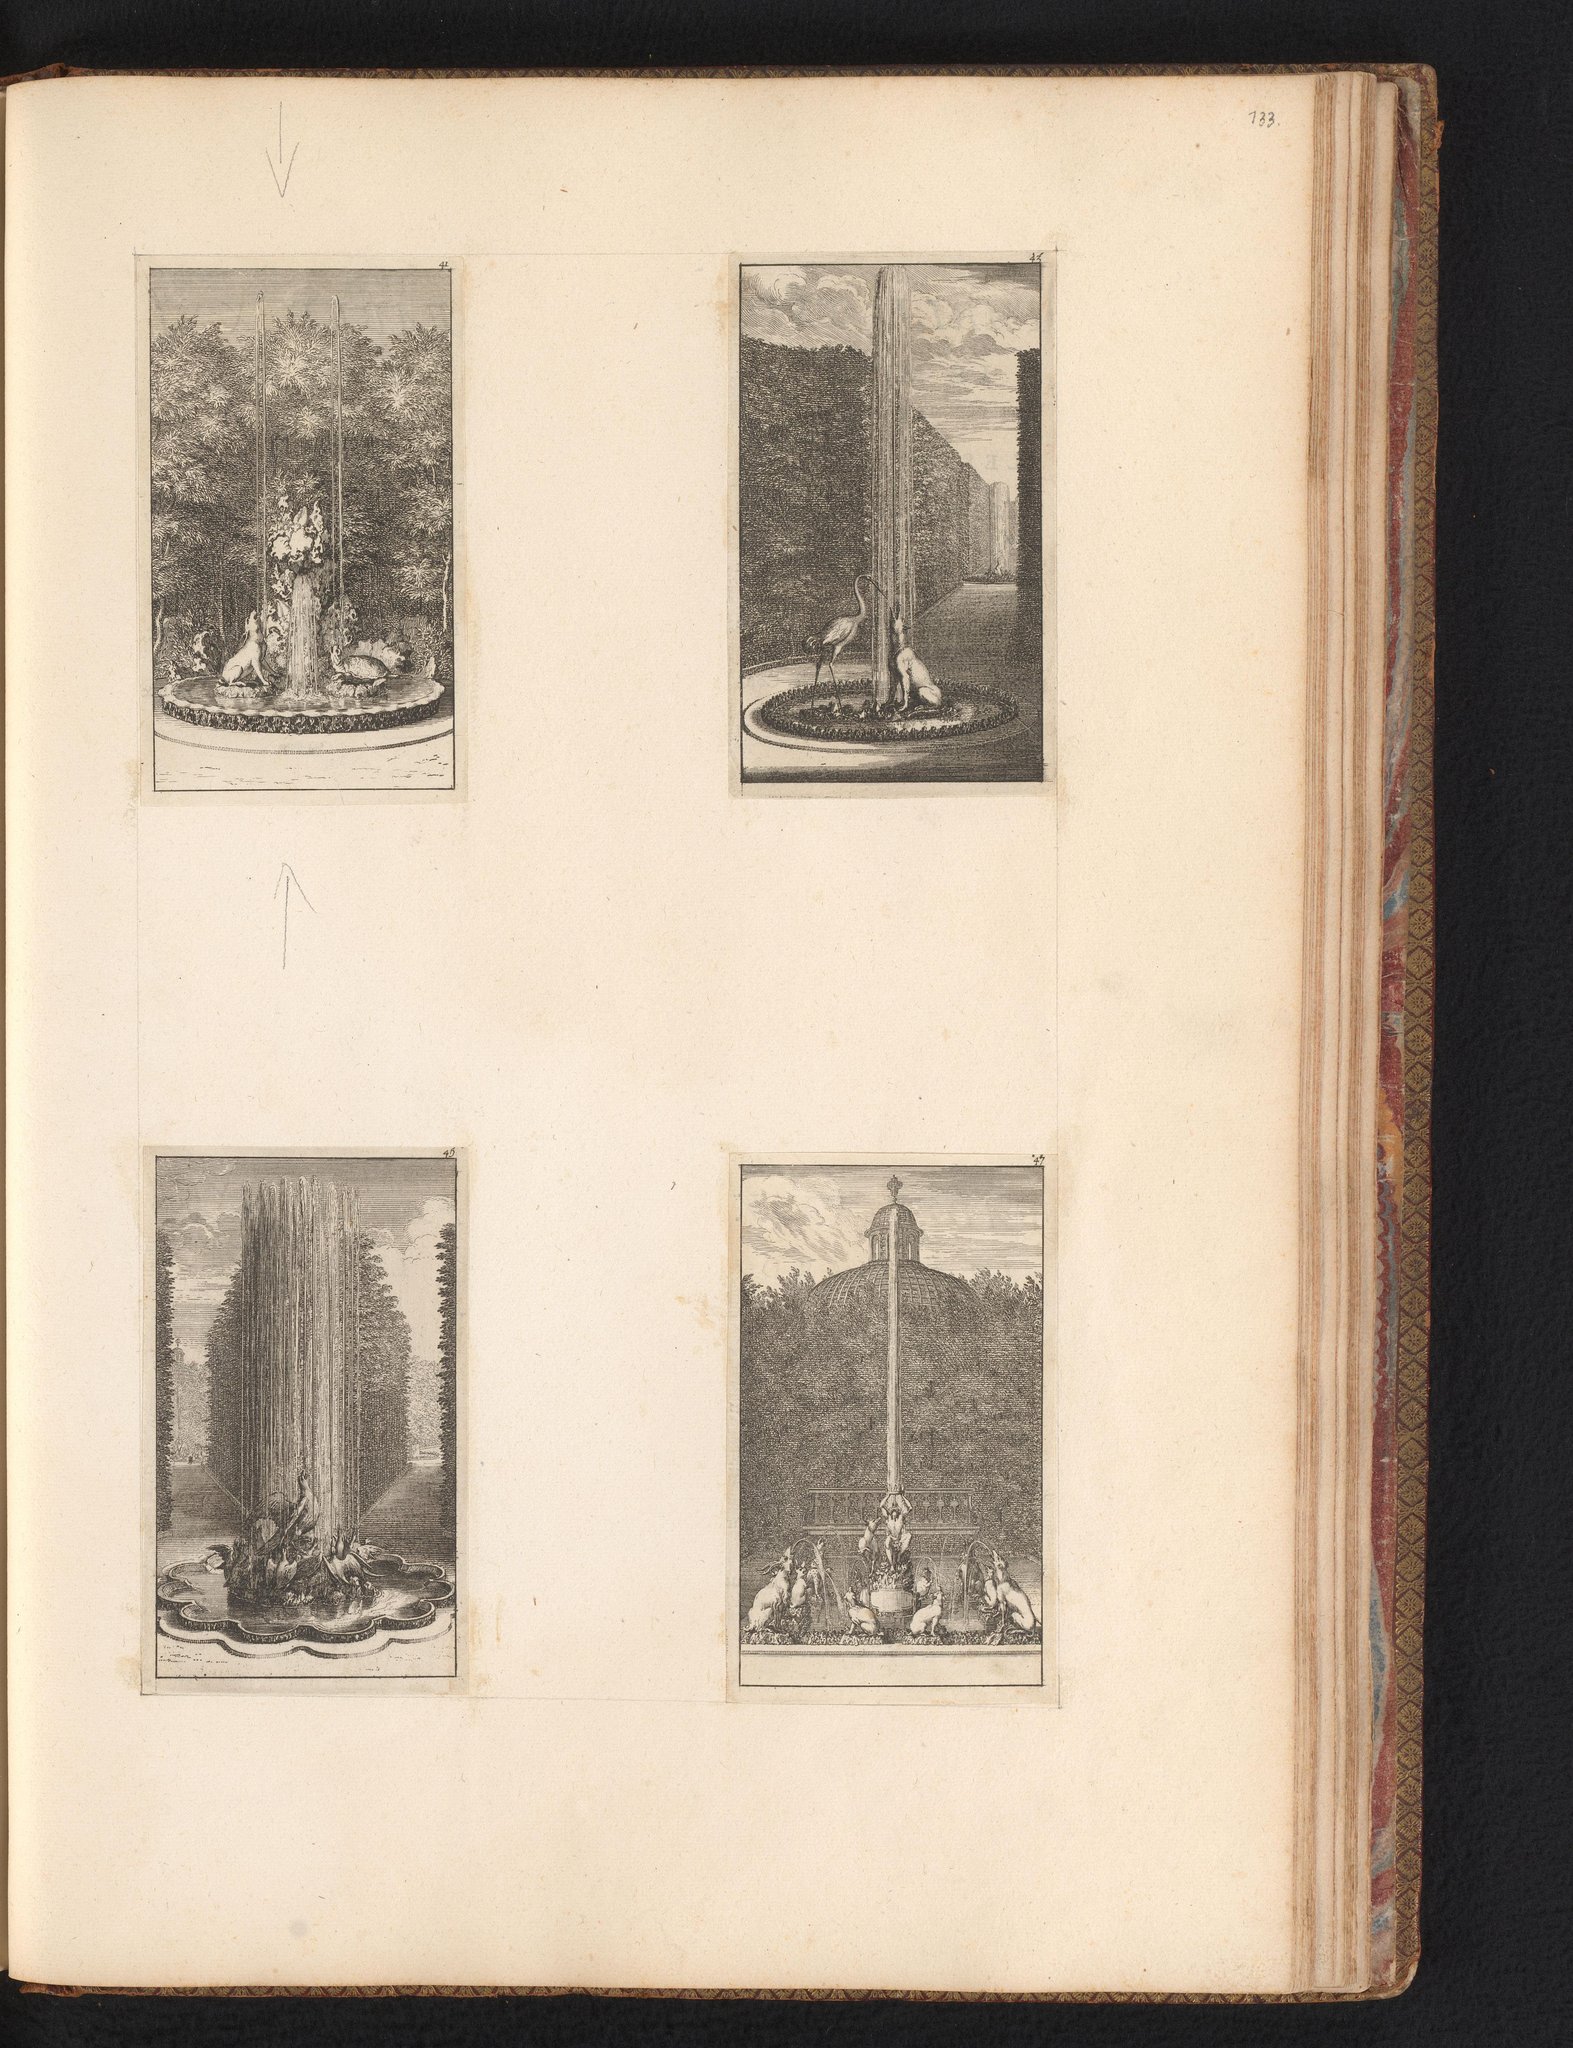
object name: album leaf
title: Vier gezichten op het labyrint van het Paleis van Versailles met fonteinen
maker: sébastien leclerc (i)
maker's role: print maker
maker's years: 1637-1714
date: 1677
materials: paper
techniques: etching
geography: paris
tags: garden fountain, fables of aesop : use 85(...), labyrinth, maze ~ garden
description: Prenten uit: Perrault, Charles. Labyrinthe de Versailles. Parijs: Imprimerie Royale, 1677. Hierin staan veertig prenten van het labyrint in de tuin van het Paleis van Versailles met verschillende fonteinen gebaseerd op de fabels van Aesopus.